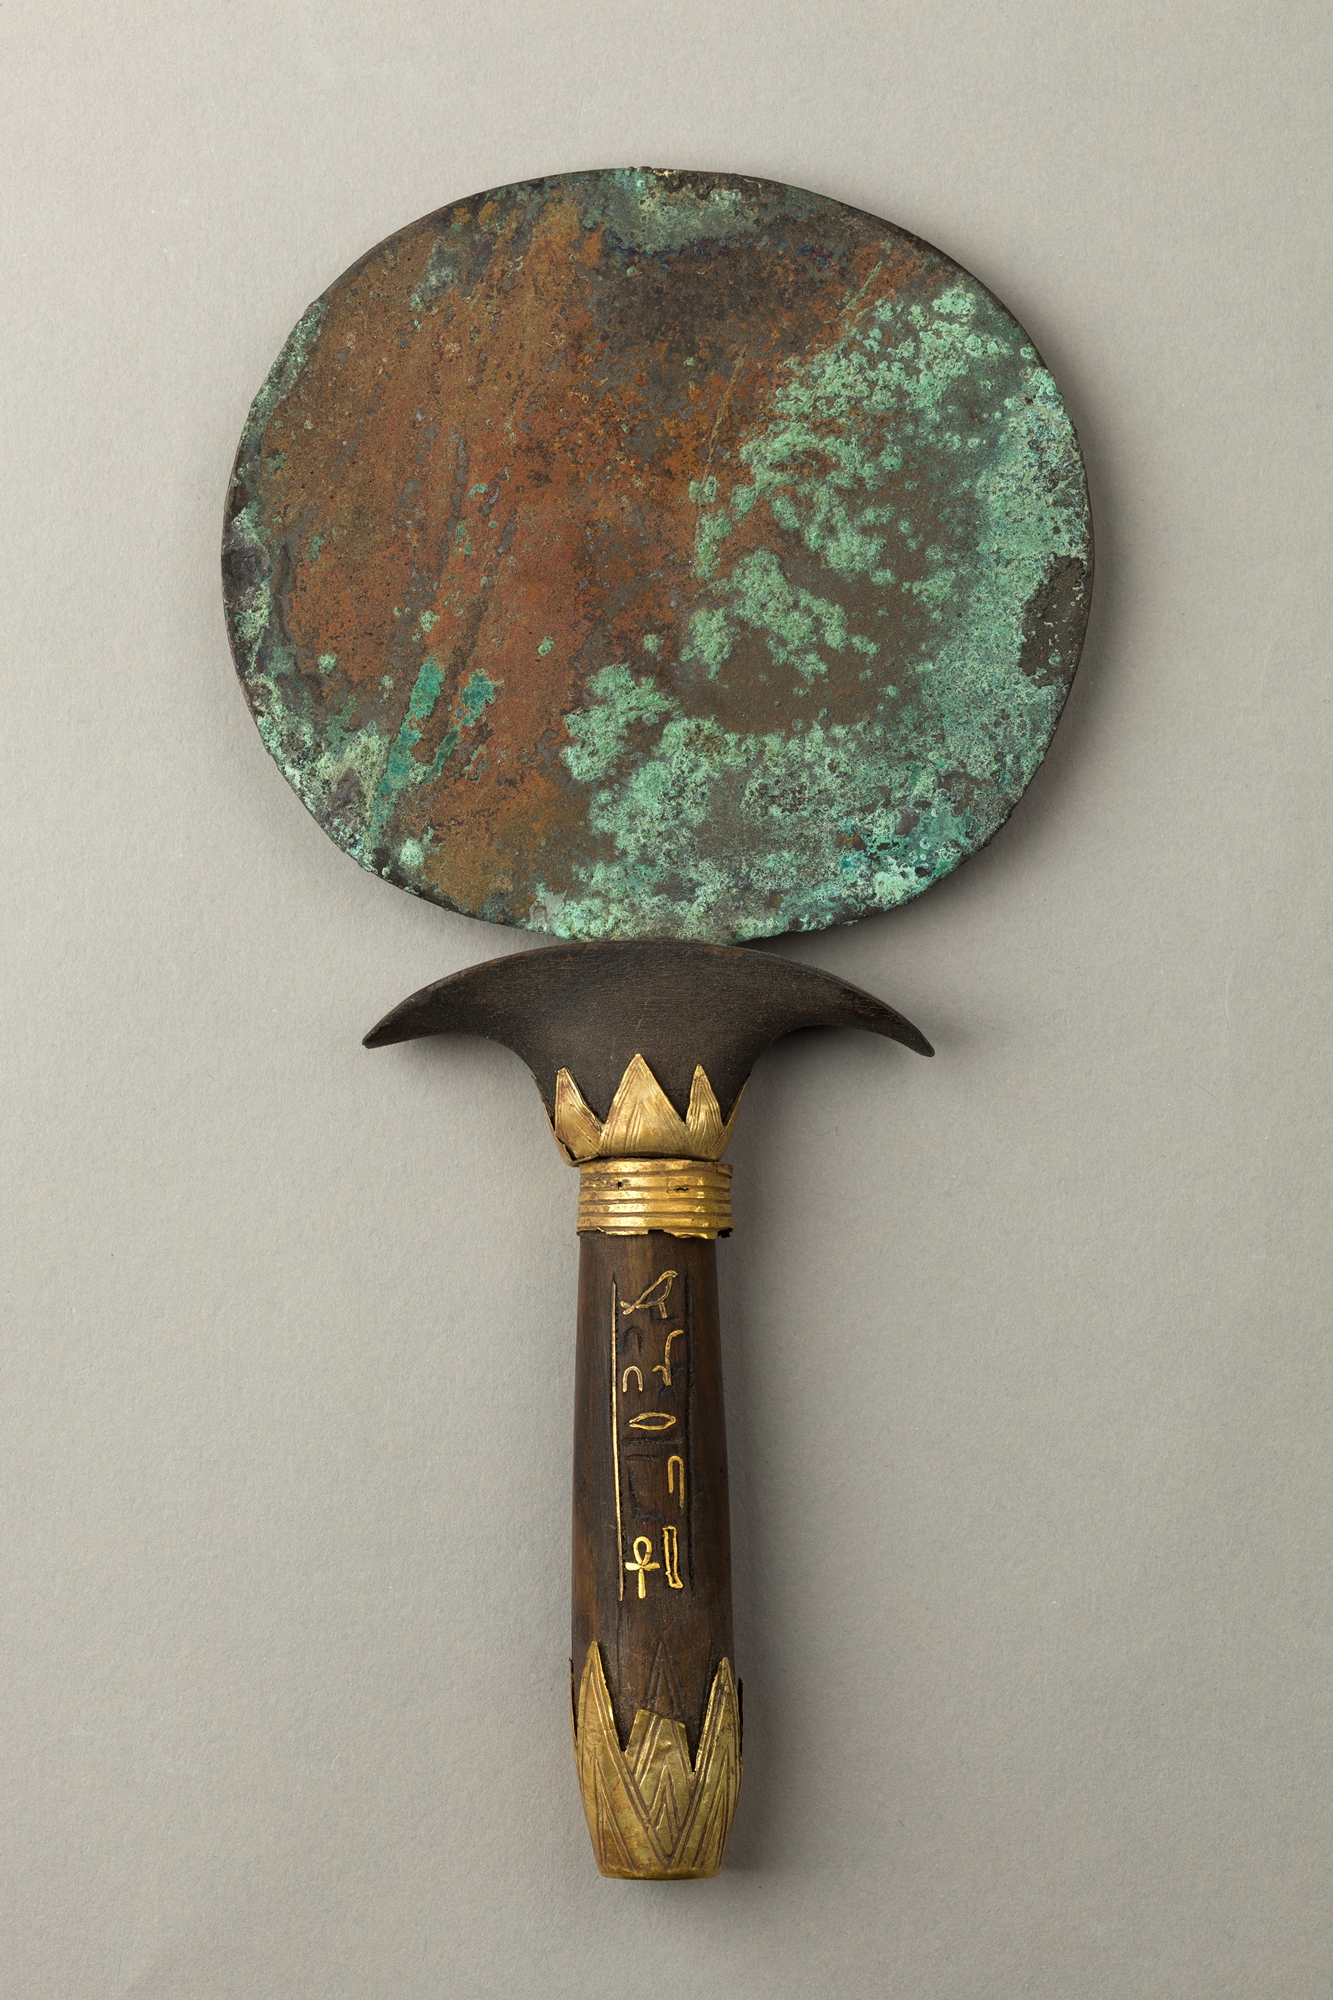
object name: mirror handle, papyrus umbel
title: Mirror of the Chief of the Southern Tens Reniseneb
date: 1810-1700 BCE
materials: copper, wood, gold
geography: egypt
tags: hieroglyphs